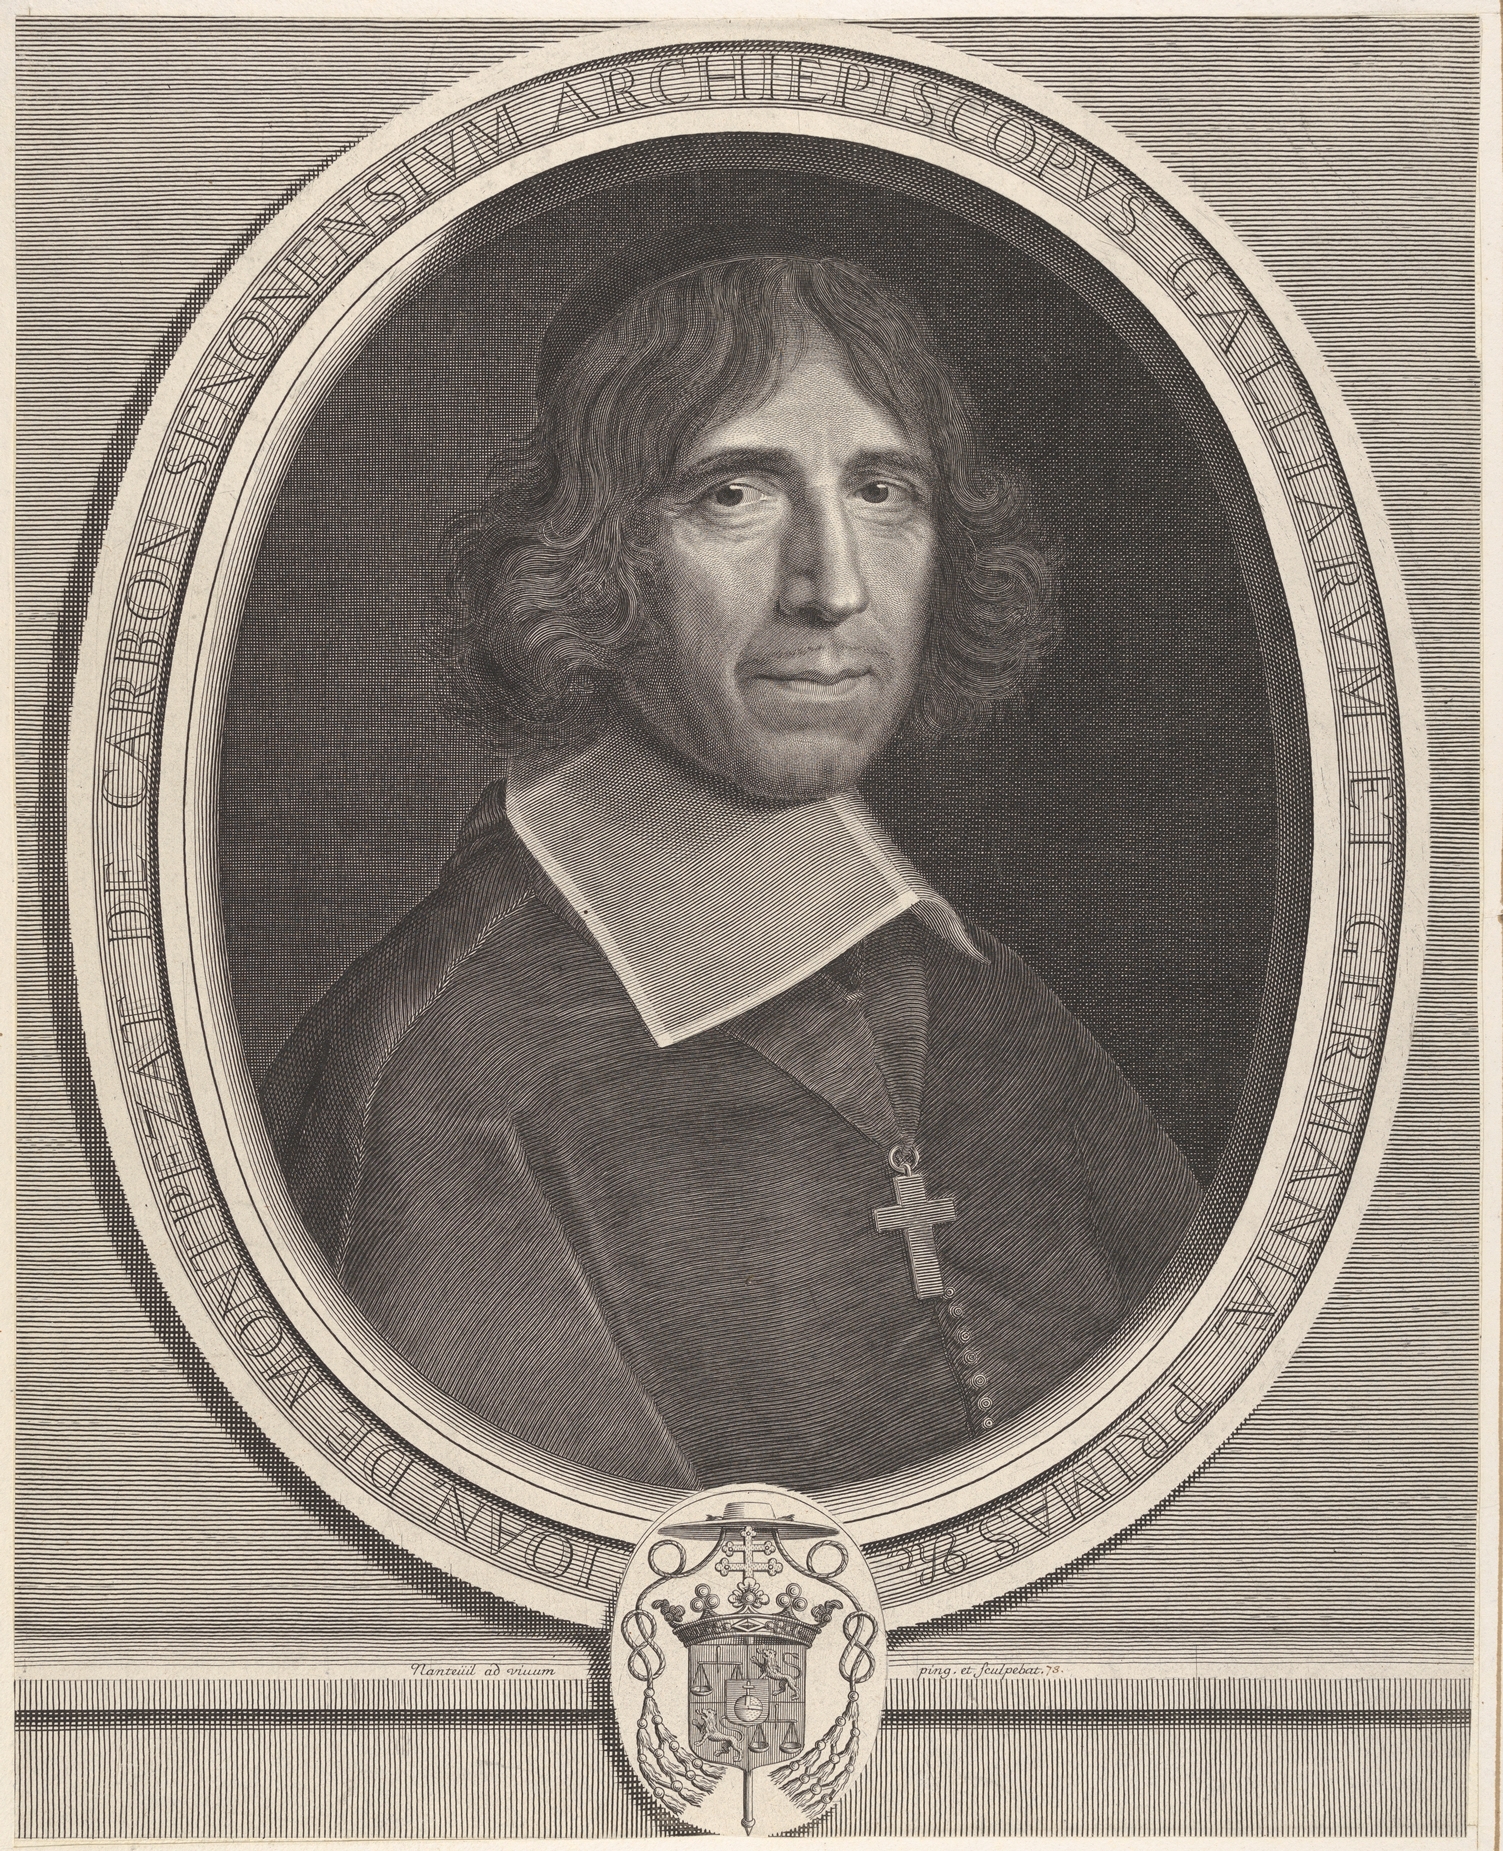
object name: print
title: Jean de Montpezat de Carbon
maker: robert nanteuil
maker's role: artist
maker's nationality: french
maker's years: 1623-1678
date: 1673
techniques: engraving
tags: men,portraits,coat of arms